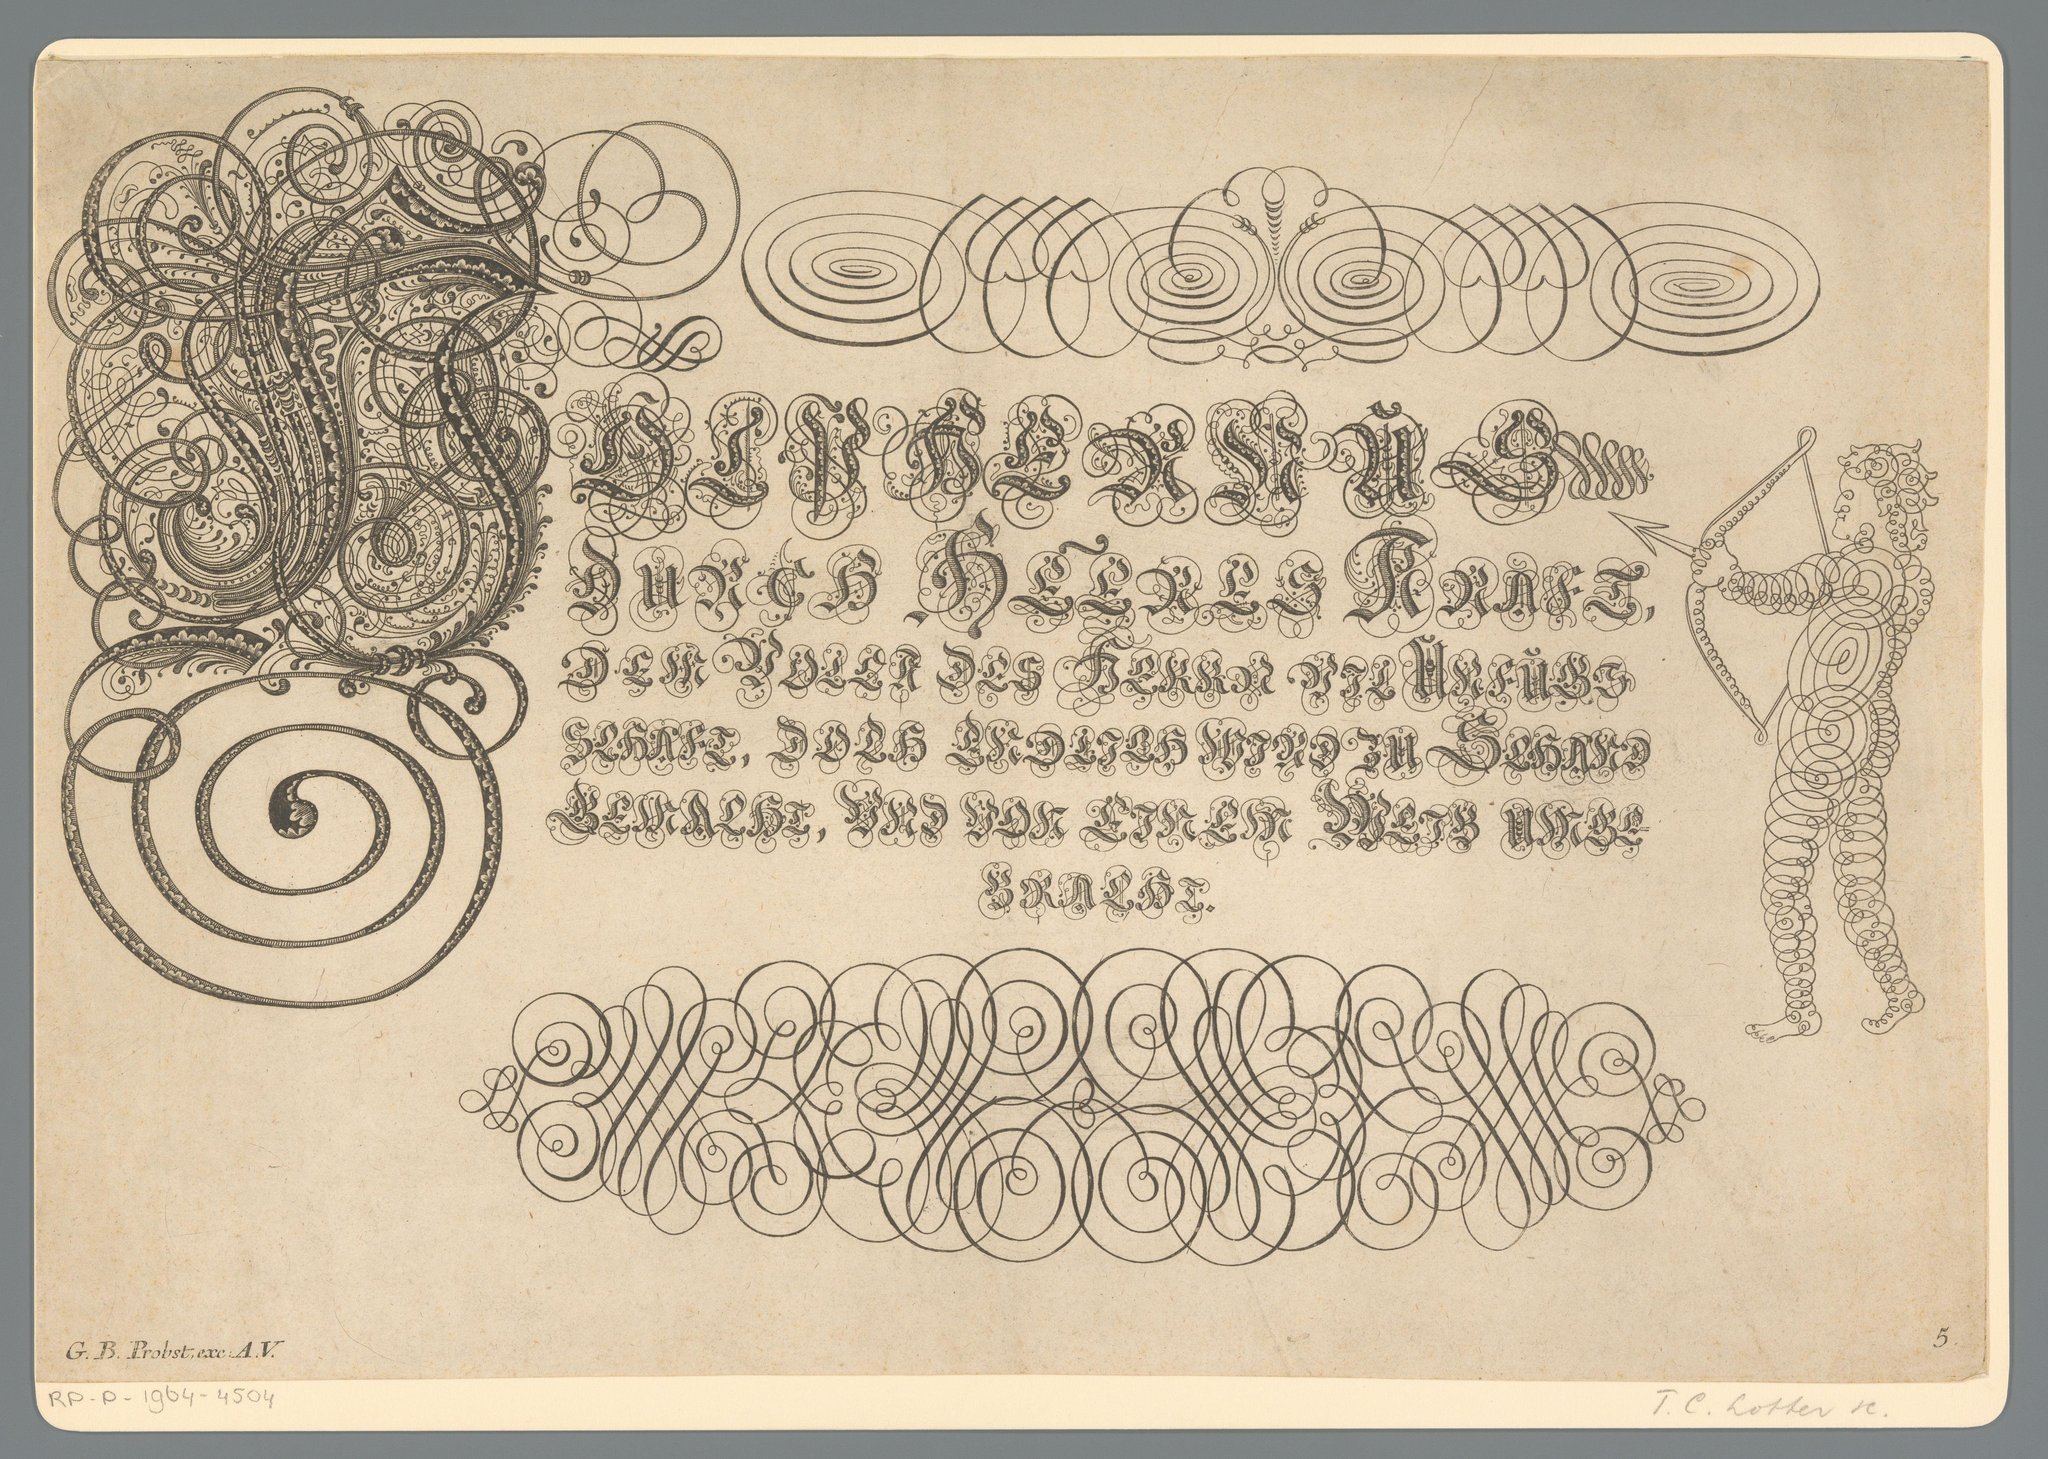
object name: print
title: Schrijfvoorbeeld (...) heraus durch Heeres Kraft (...)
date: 1766-1777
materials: paper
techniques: engraving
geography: augsburg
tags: calligraphy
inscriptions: collector's mark: Lugt 2760, collector's mark: Lugt 2228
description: Gekalligrafeerde tekst: (...) heraus durch Heeres Kraft, dem Volck des herrn (...). Rechts een kalligrafische voorstelling van een boogschutter.